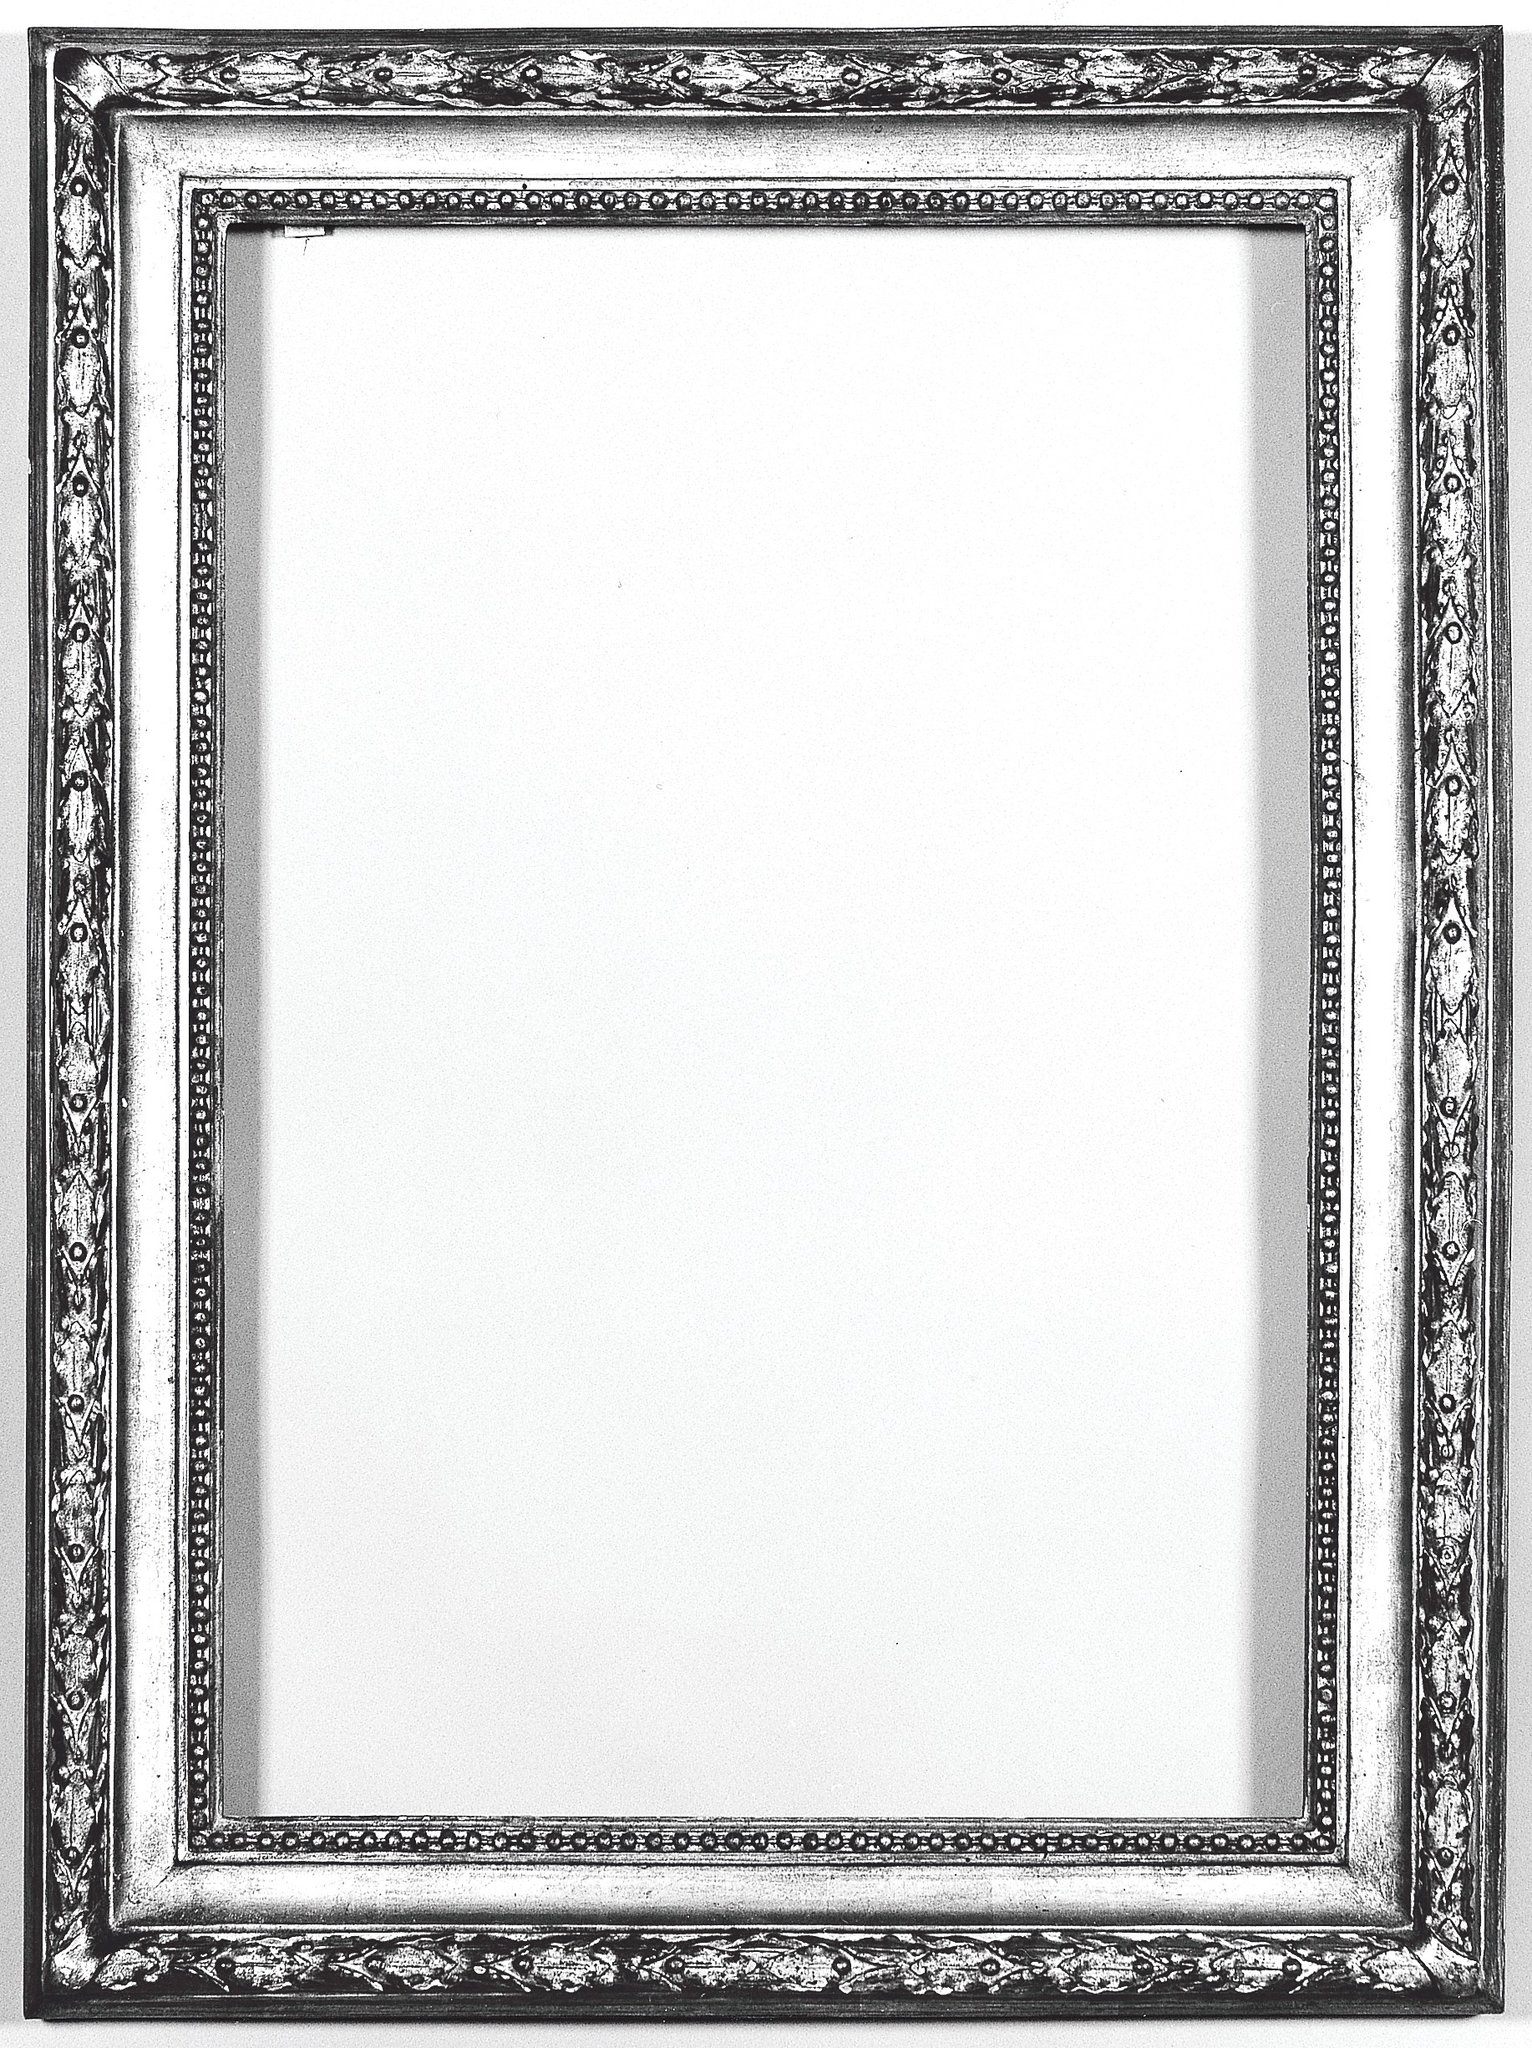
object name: frame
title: Neoclassical frame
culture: italian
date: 1780-1800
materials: wood